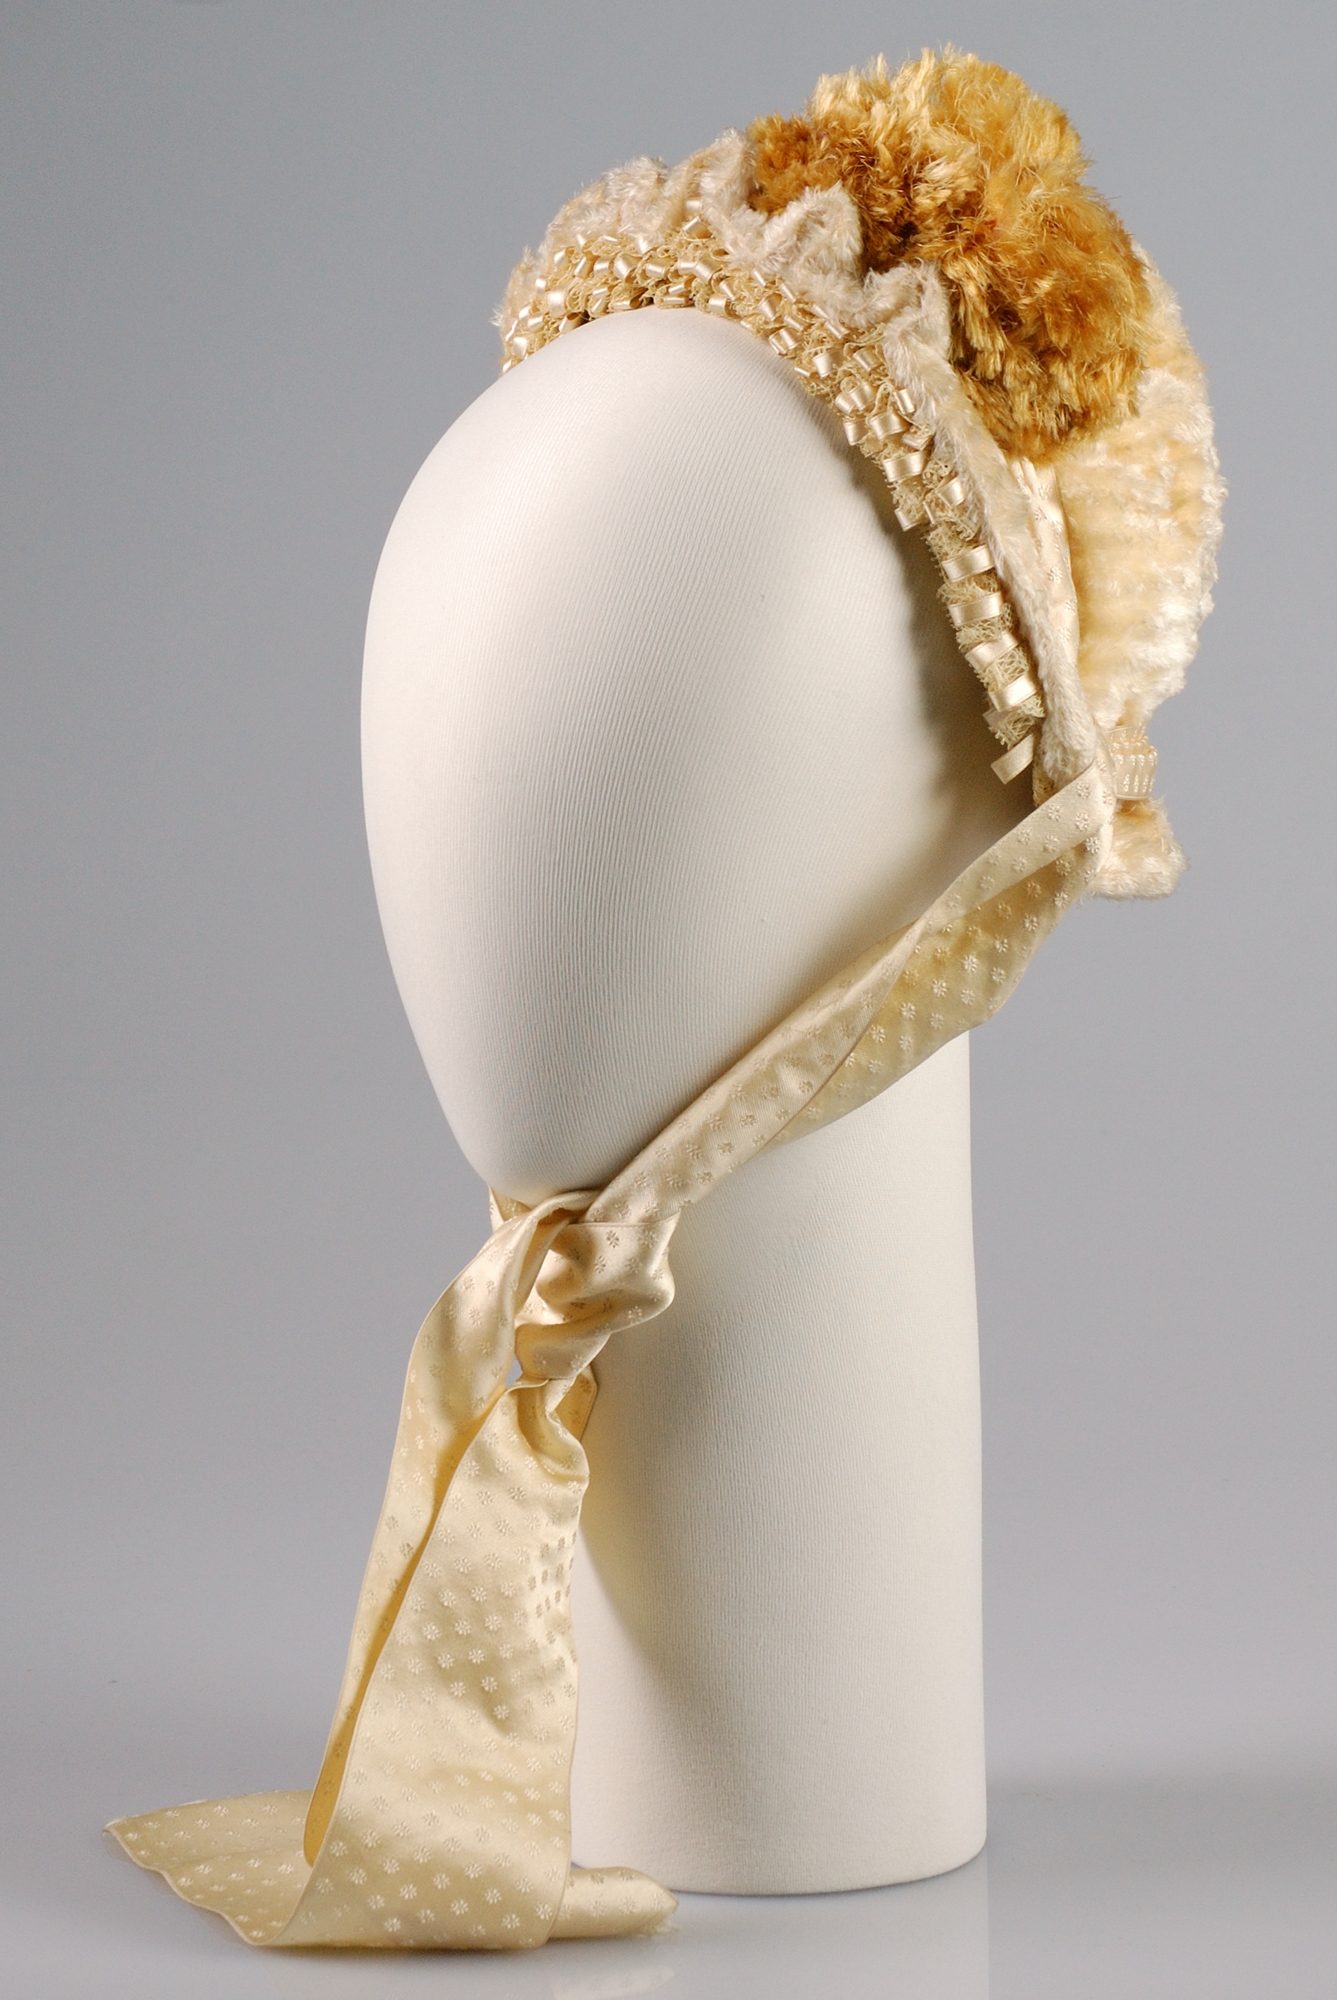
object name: bonnet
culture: american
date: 1885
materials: linen, silk